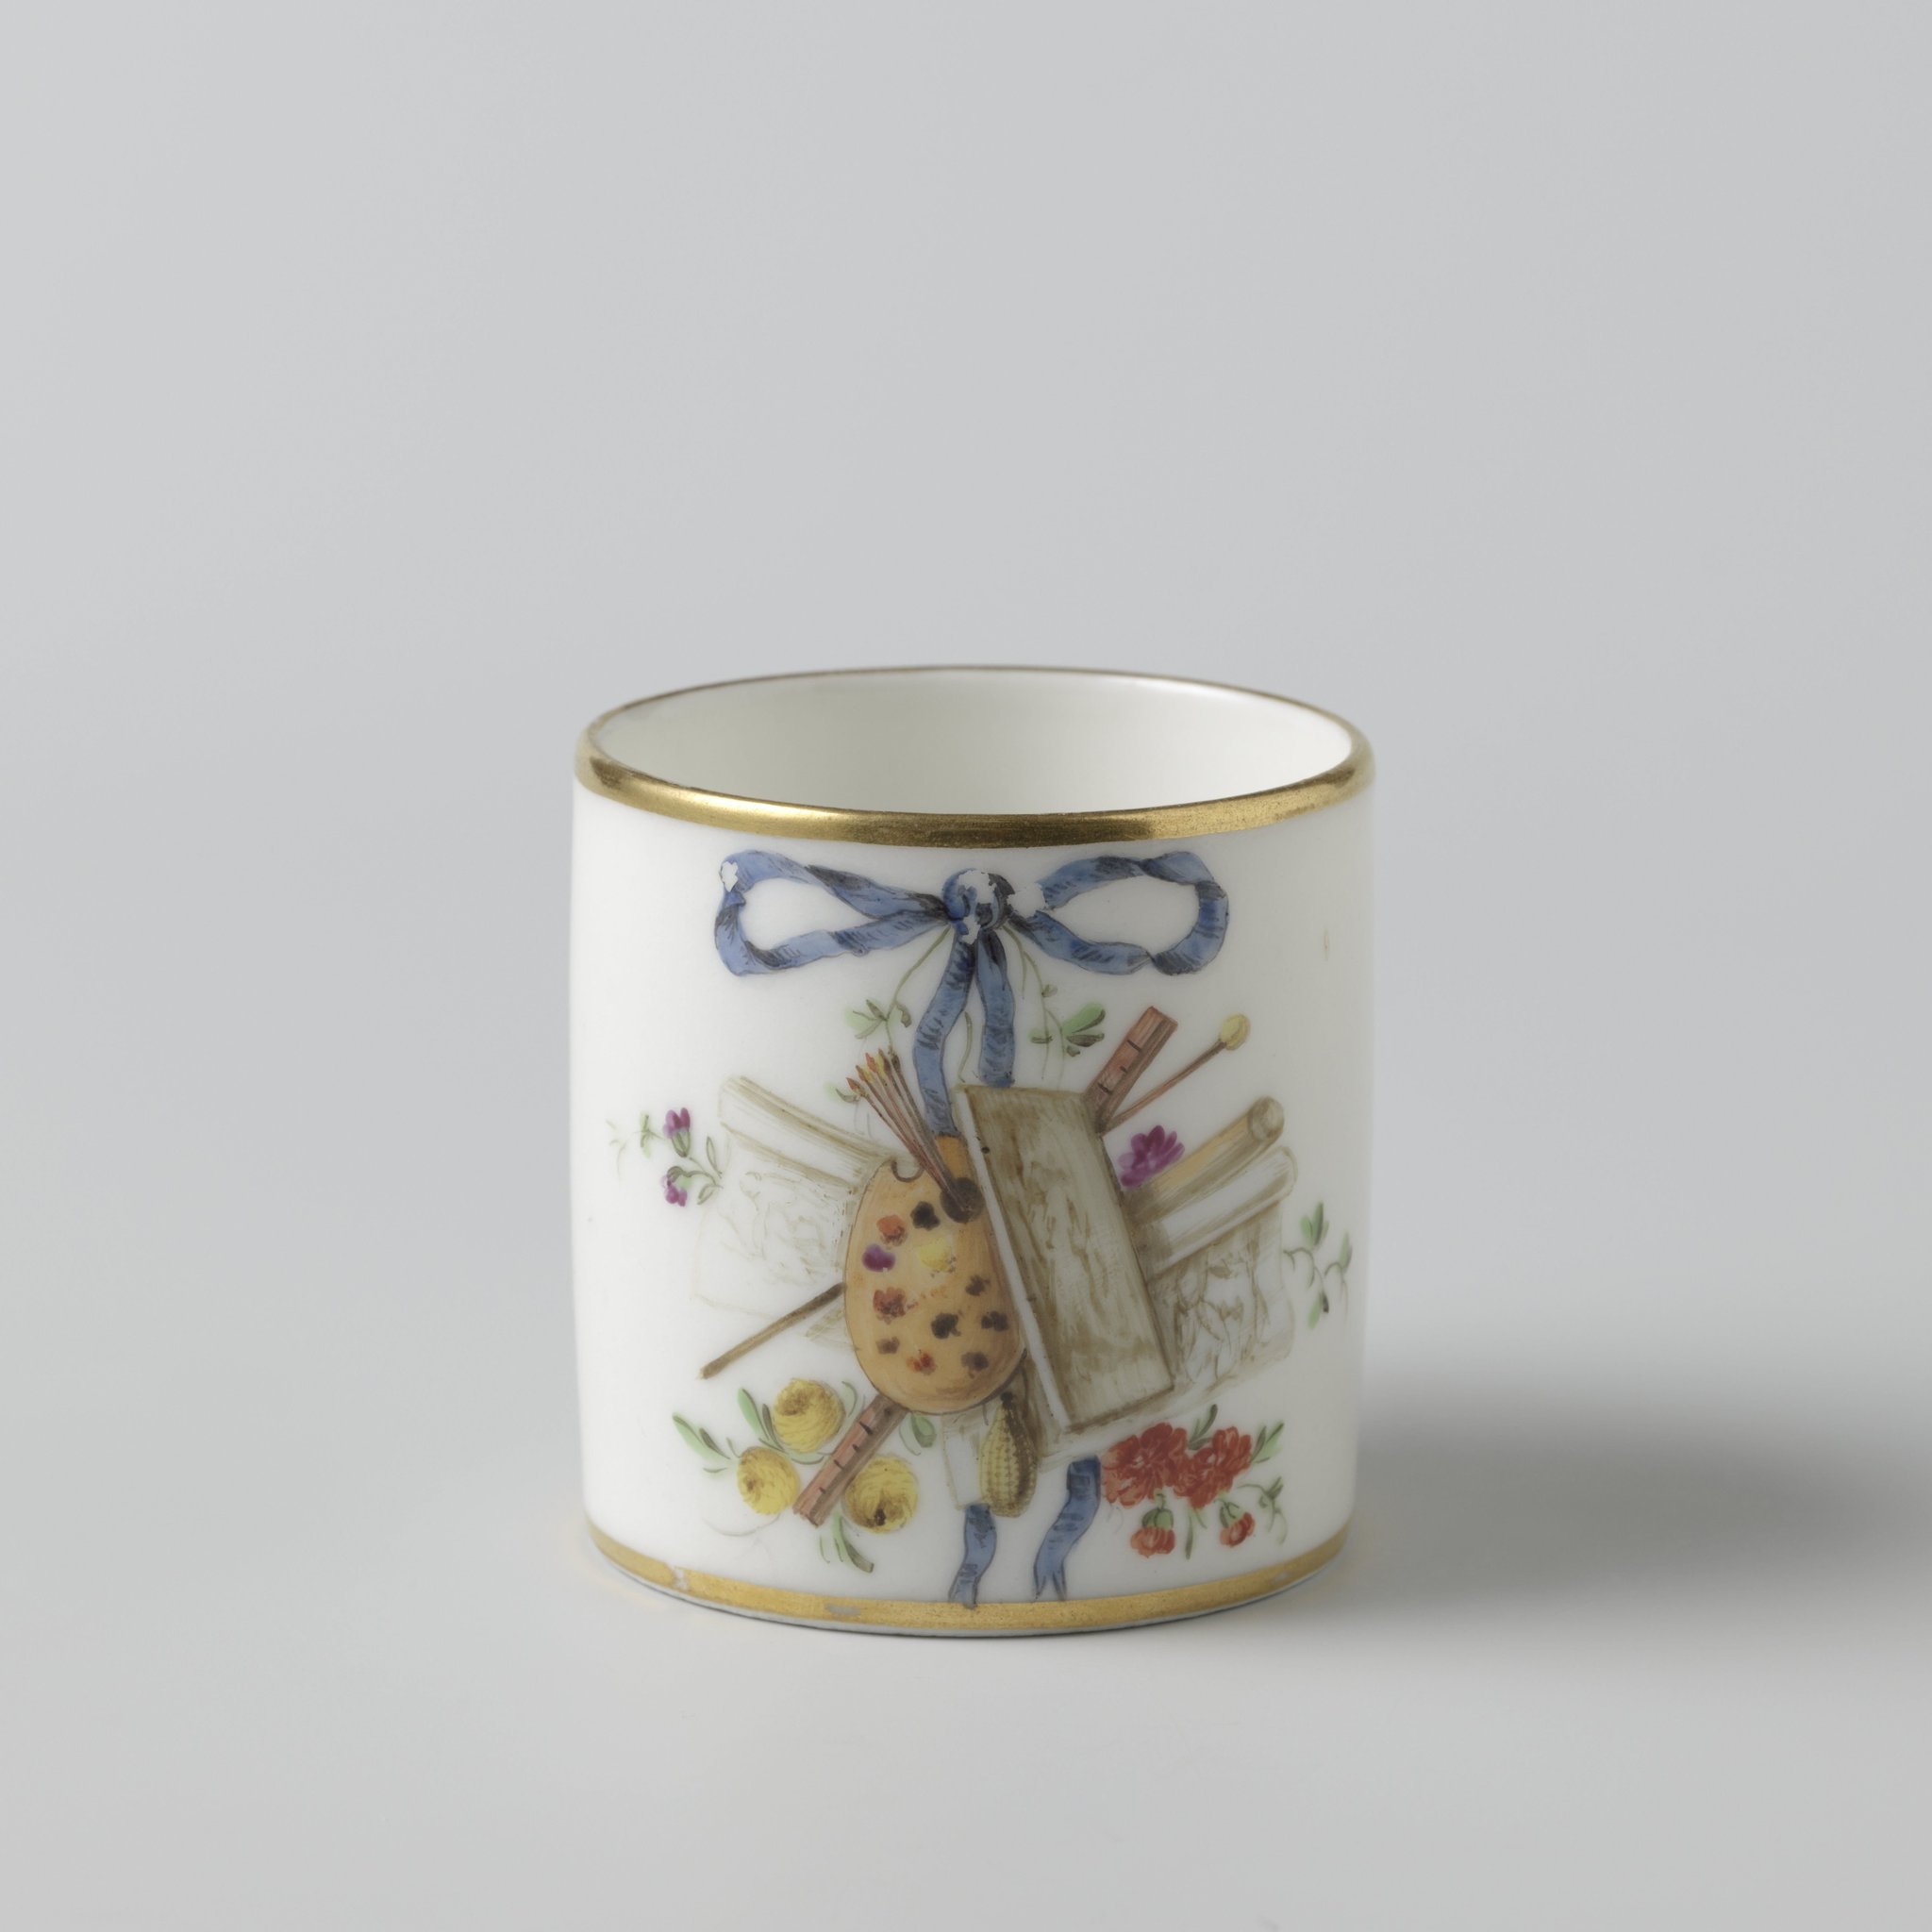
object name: cup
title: Theekop met decoratie van trofeeën aan gestrikte linten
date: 1809-1814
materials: porcelain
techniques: painted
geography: nieuwer-amstel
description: Theeservies bestaande uit een theepot, een suikerpot, een spoelkom en twaalf koppen en schotels veelkleurig beschilderd met trofeeën hangend aan blauwe strikken. De trofeeën hebben betrekking op diverse beroepen. Gemerkt in zwart: Amstel (de suikerpot Amstel N. 805 en ingegrift A). Verschillende ingegrifte merken in de koppen en schotels.